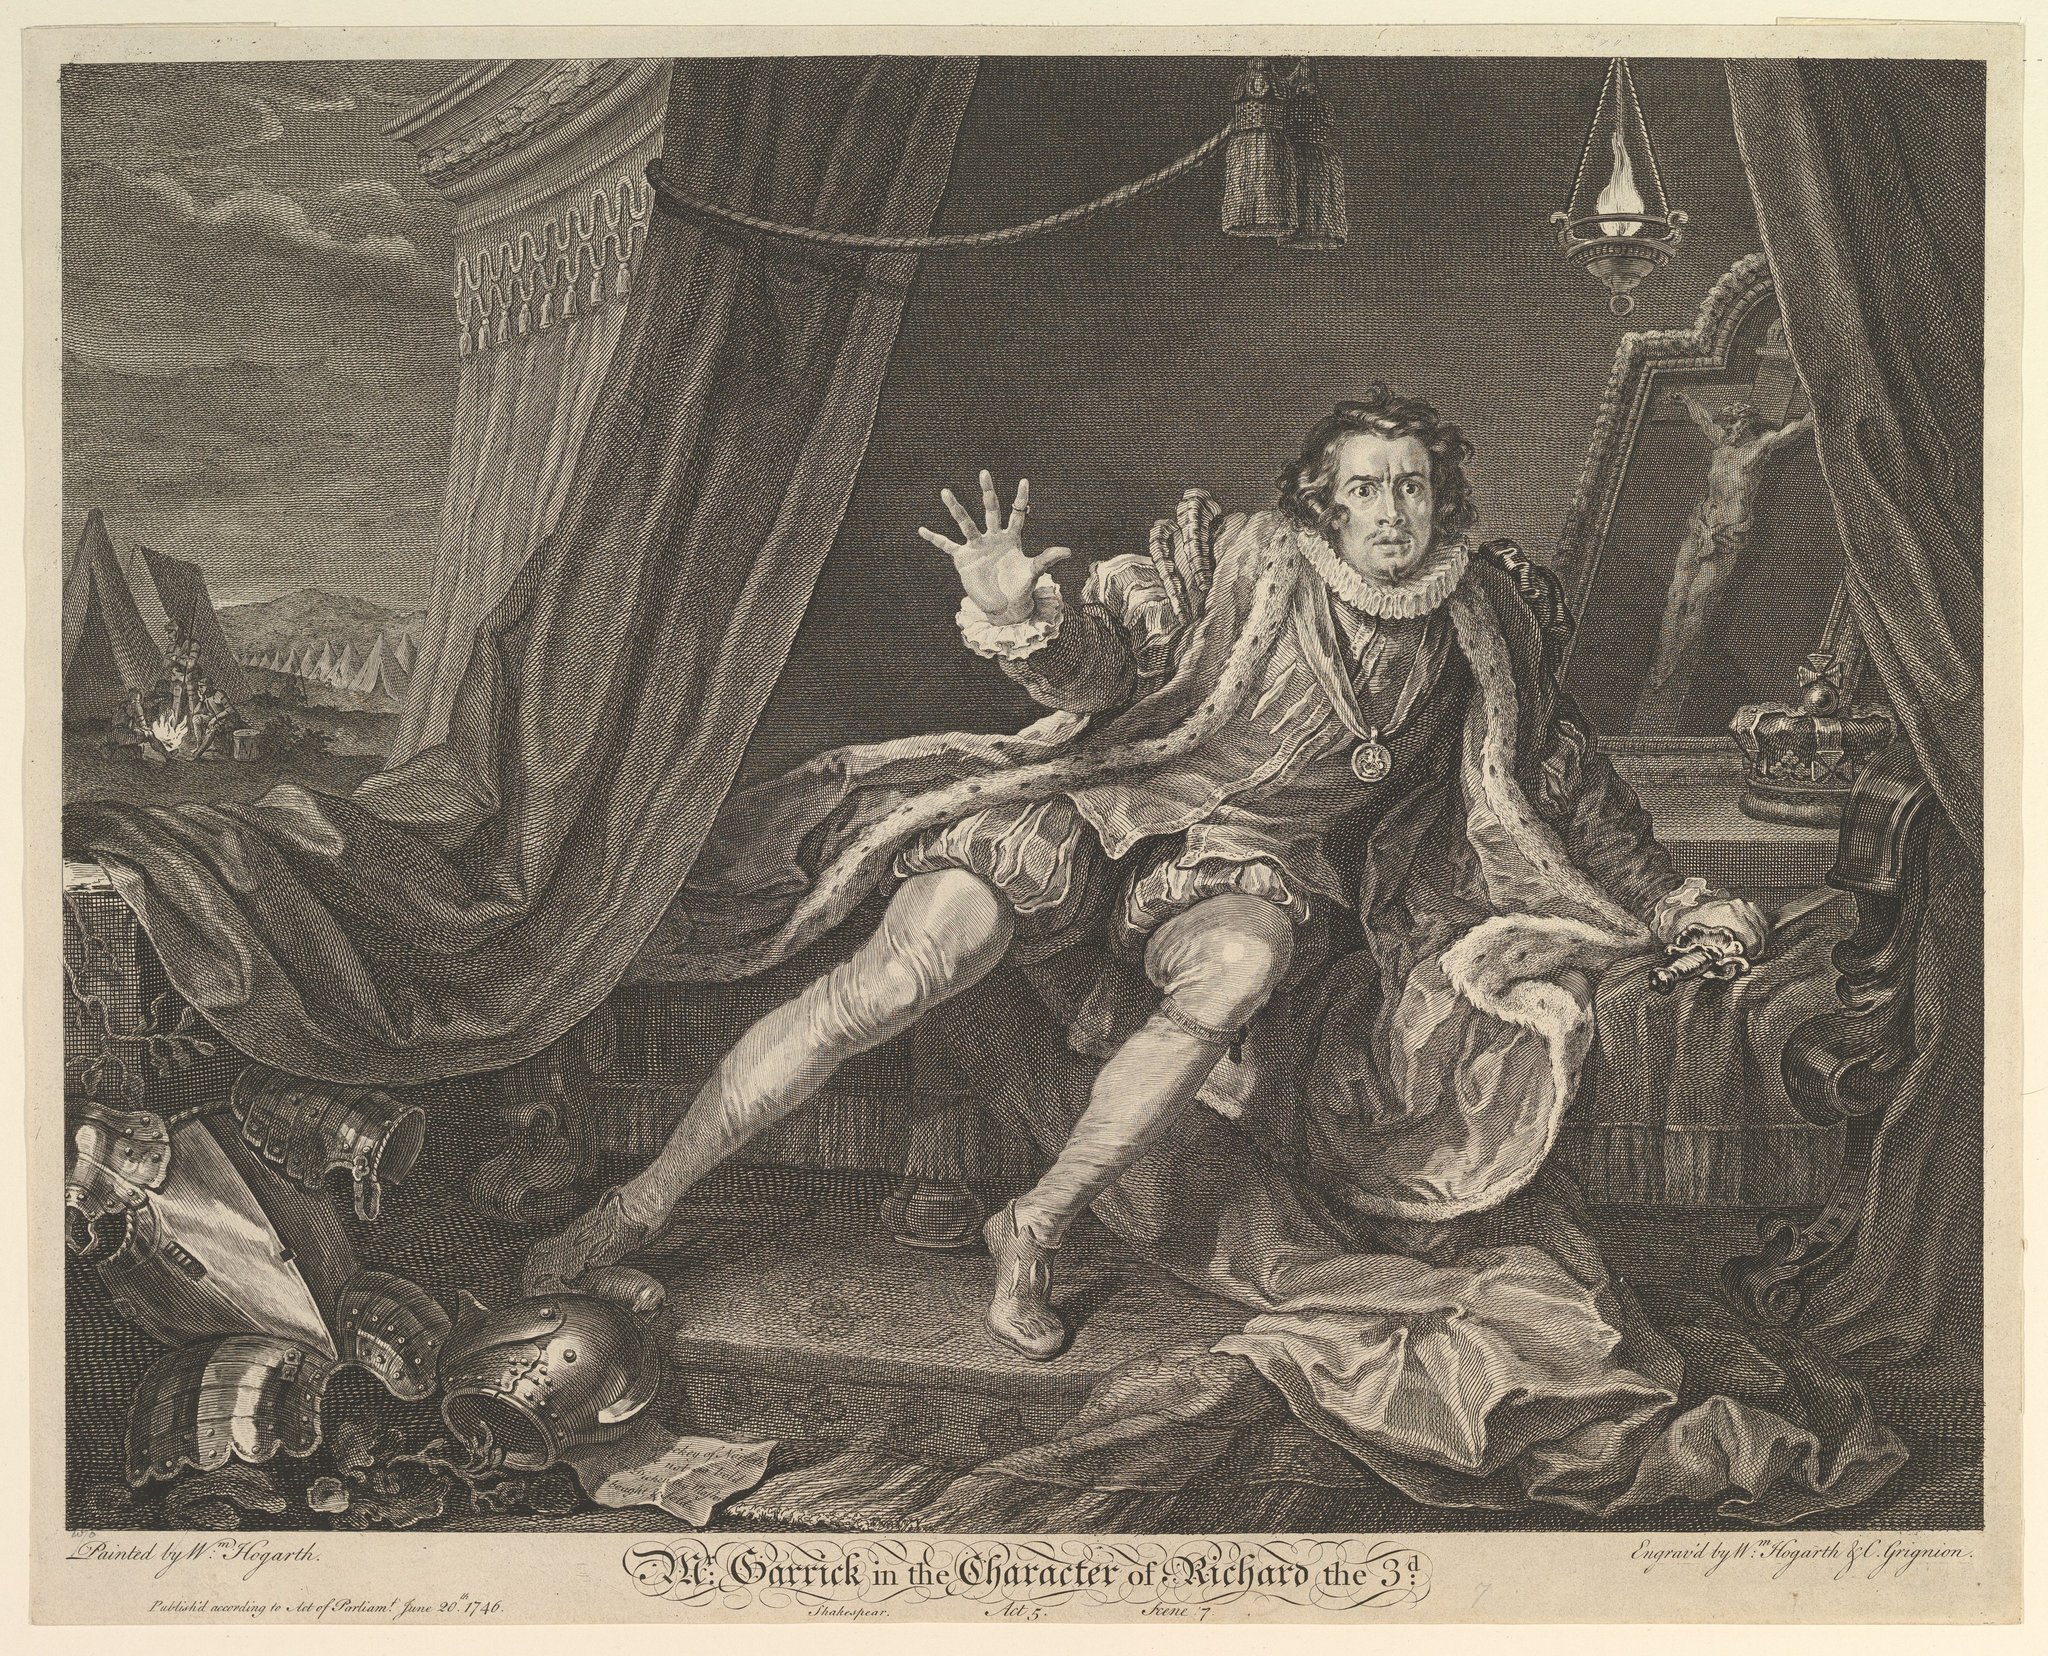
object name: print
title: Mr. Garrick in the Character of Richard III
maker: william hogarth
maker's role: artist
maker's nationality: british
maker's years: 1697-1764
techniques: engraving, etching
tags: shakespeare,men,actors